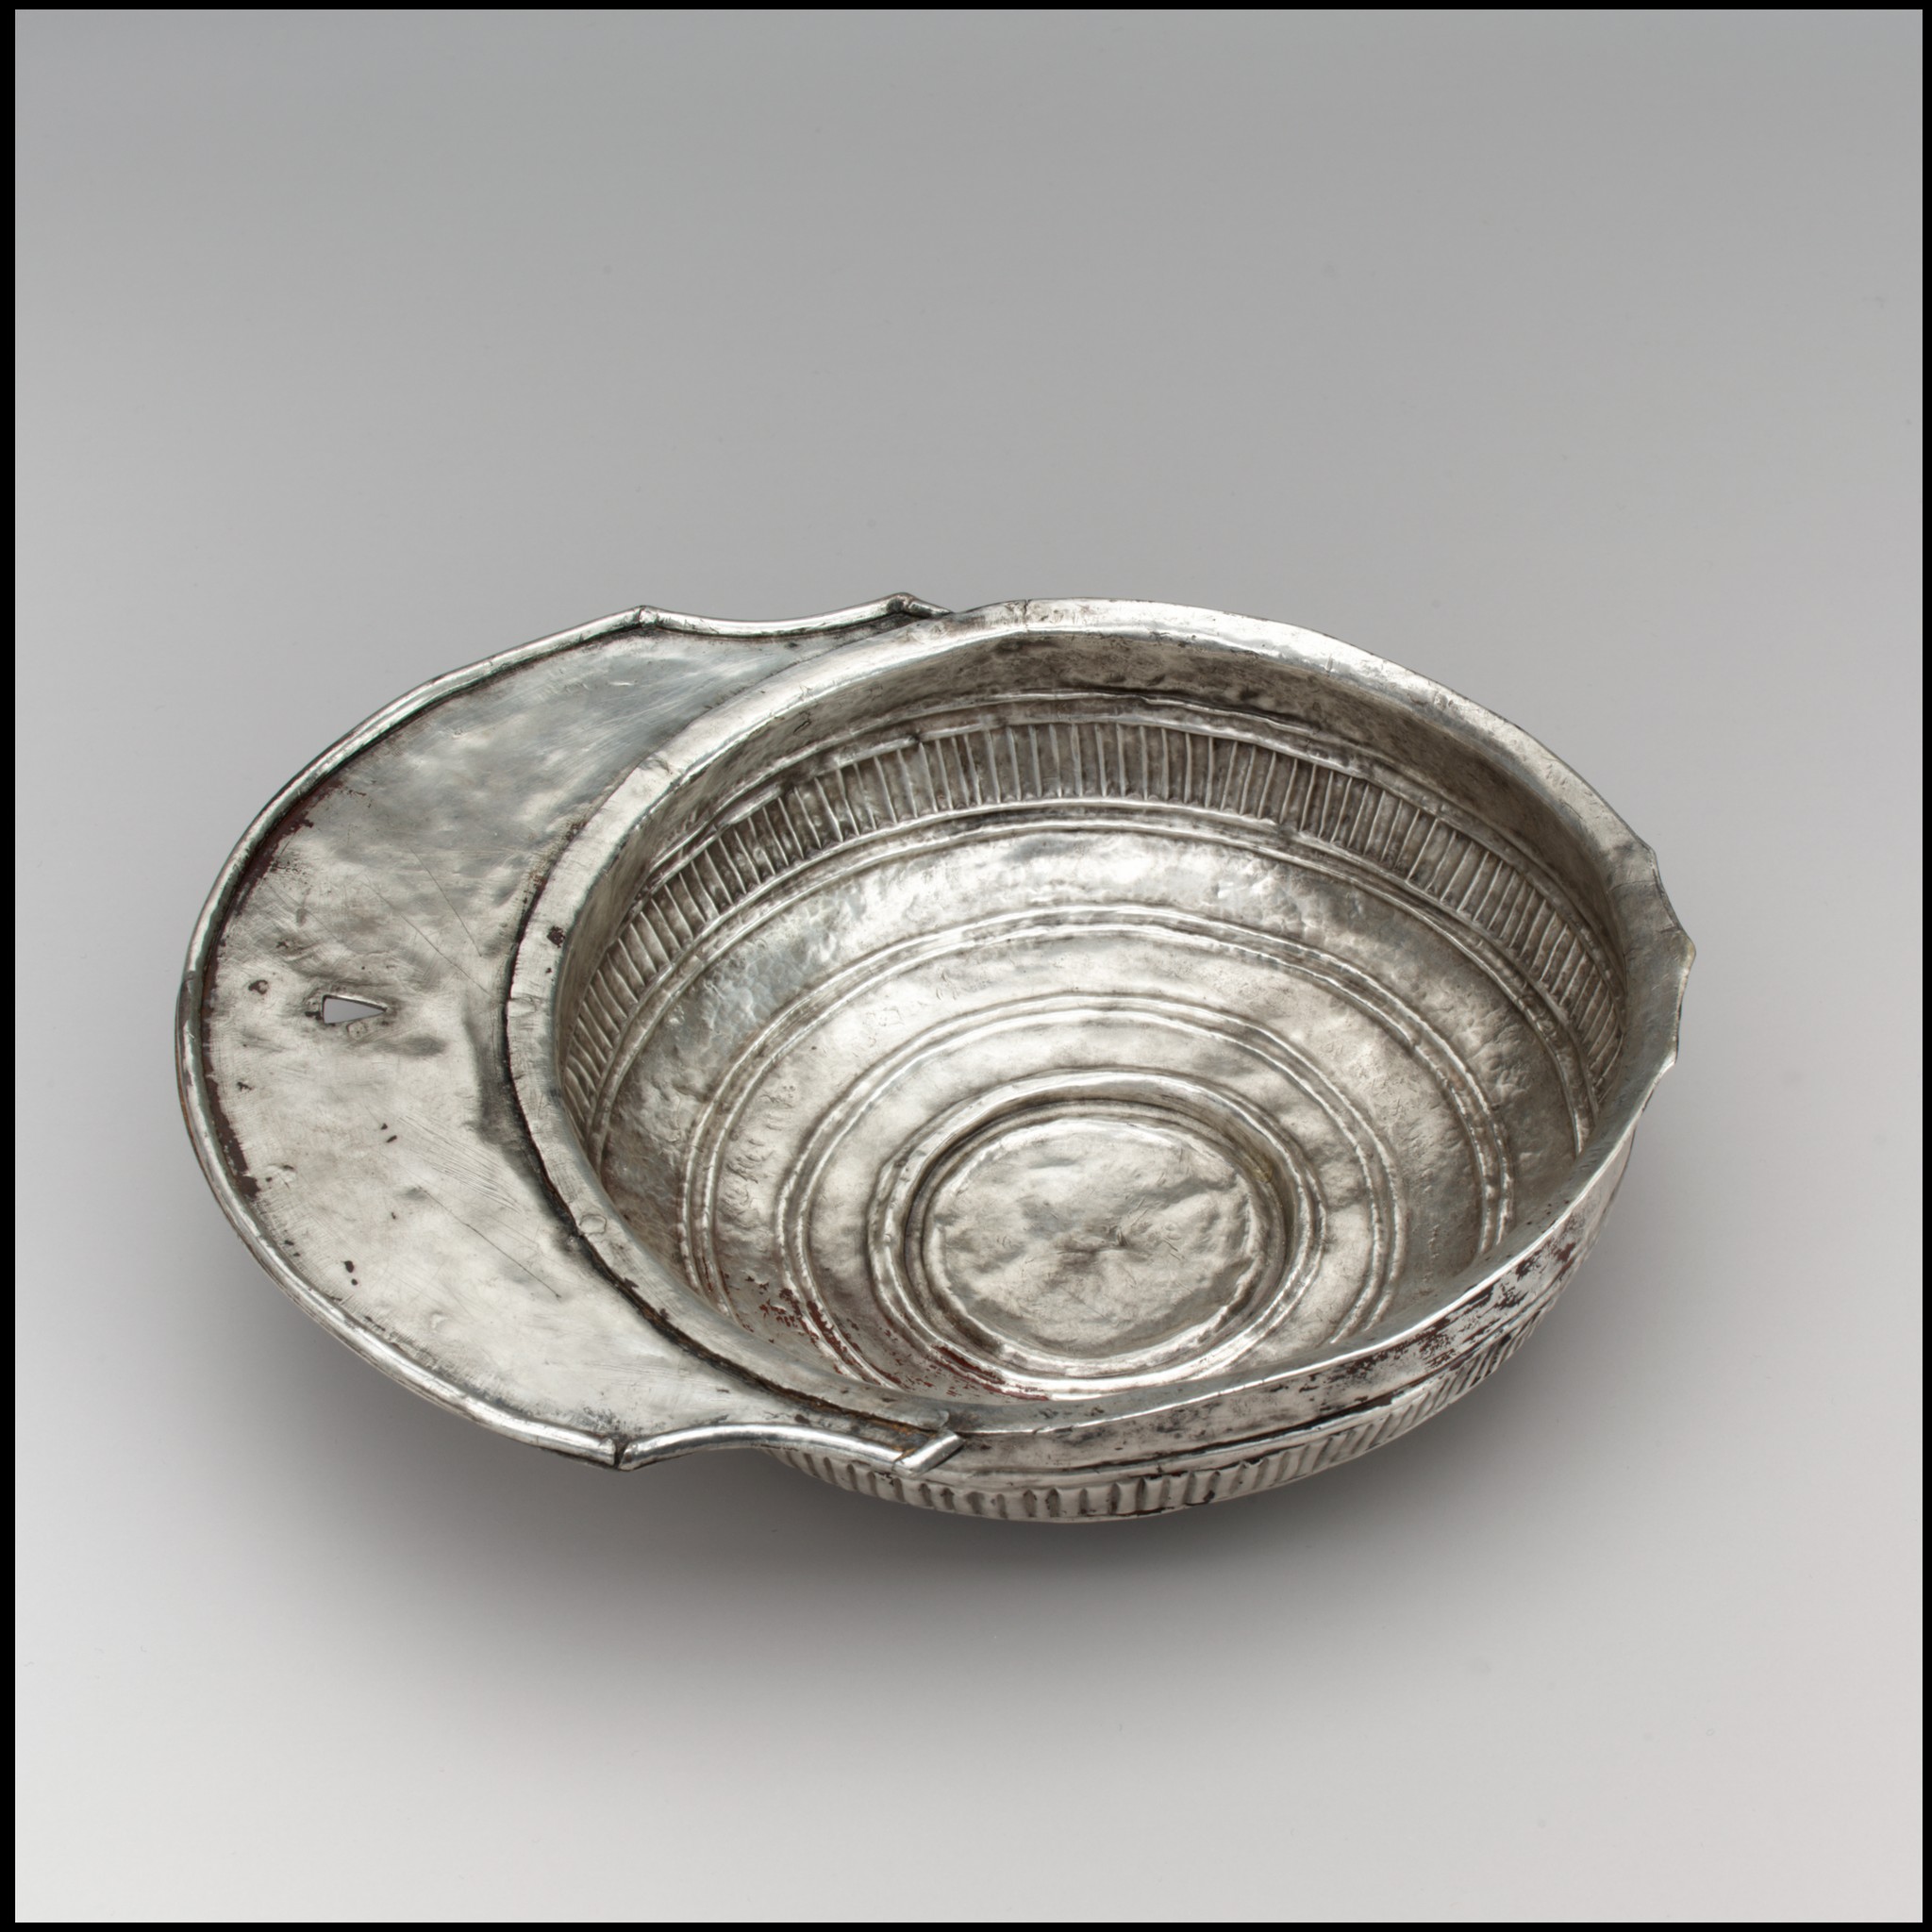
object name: bowl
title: Silver Drinking Bowl with Handle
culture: avar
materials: silver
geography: tirana